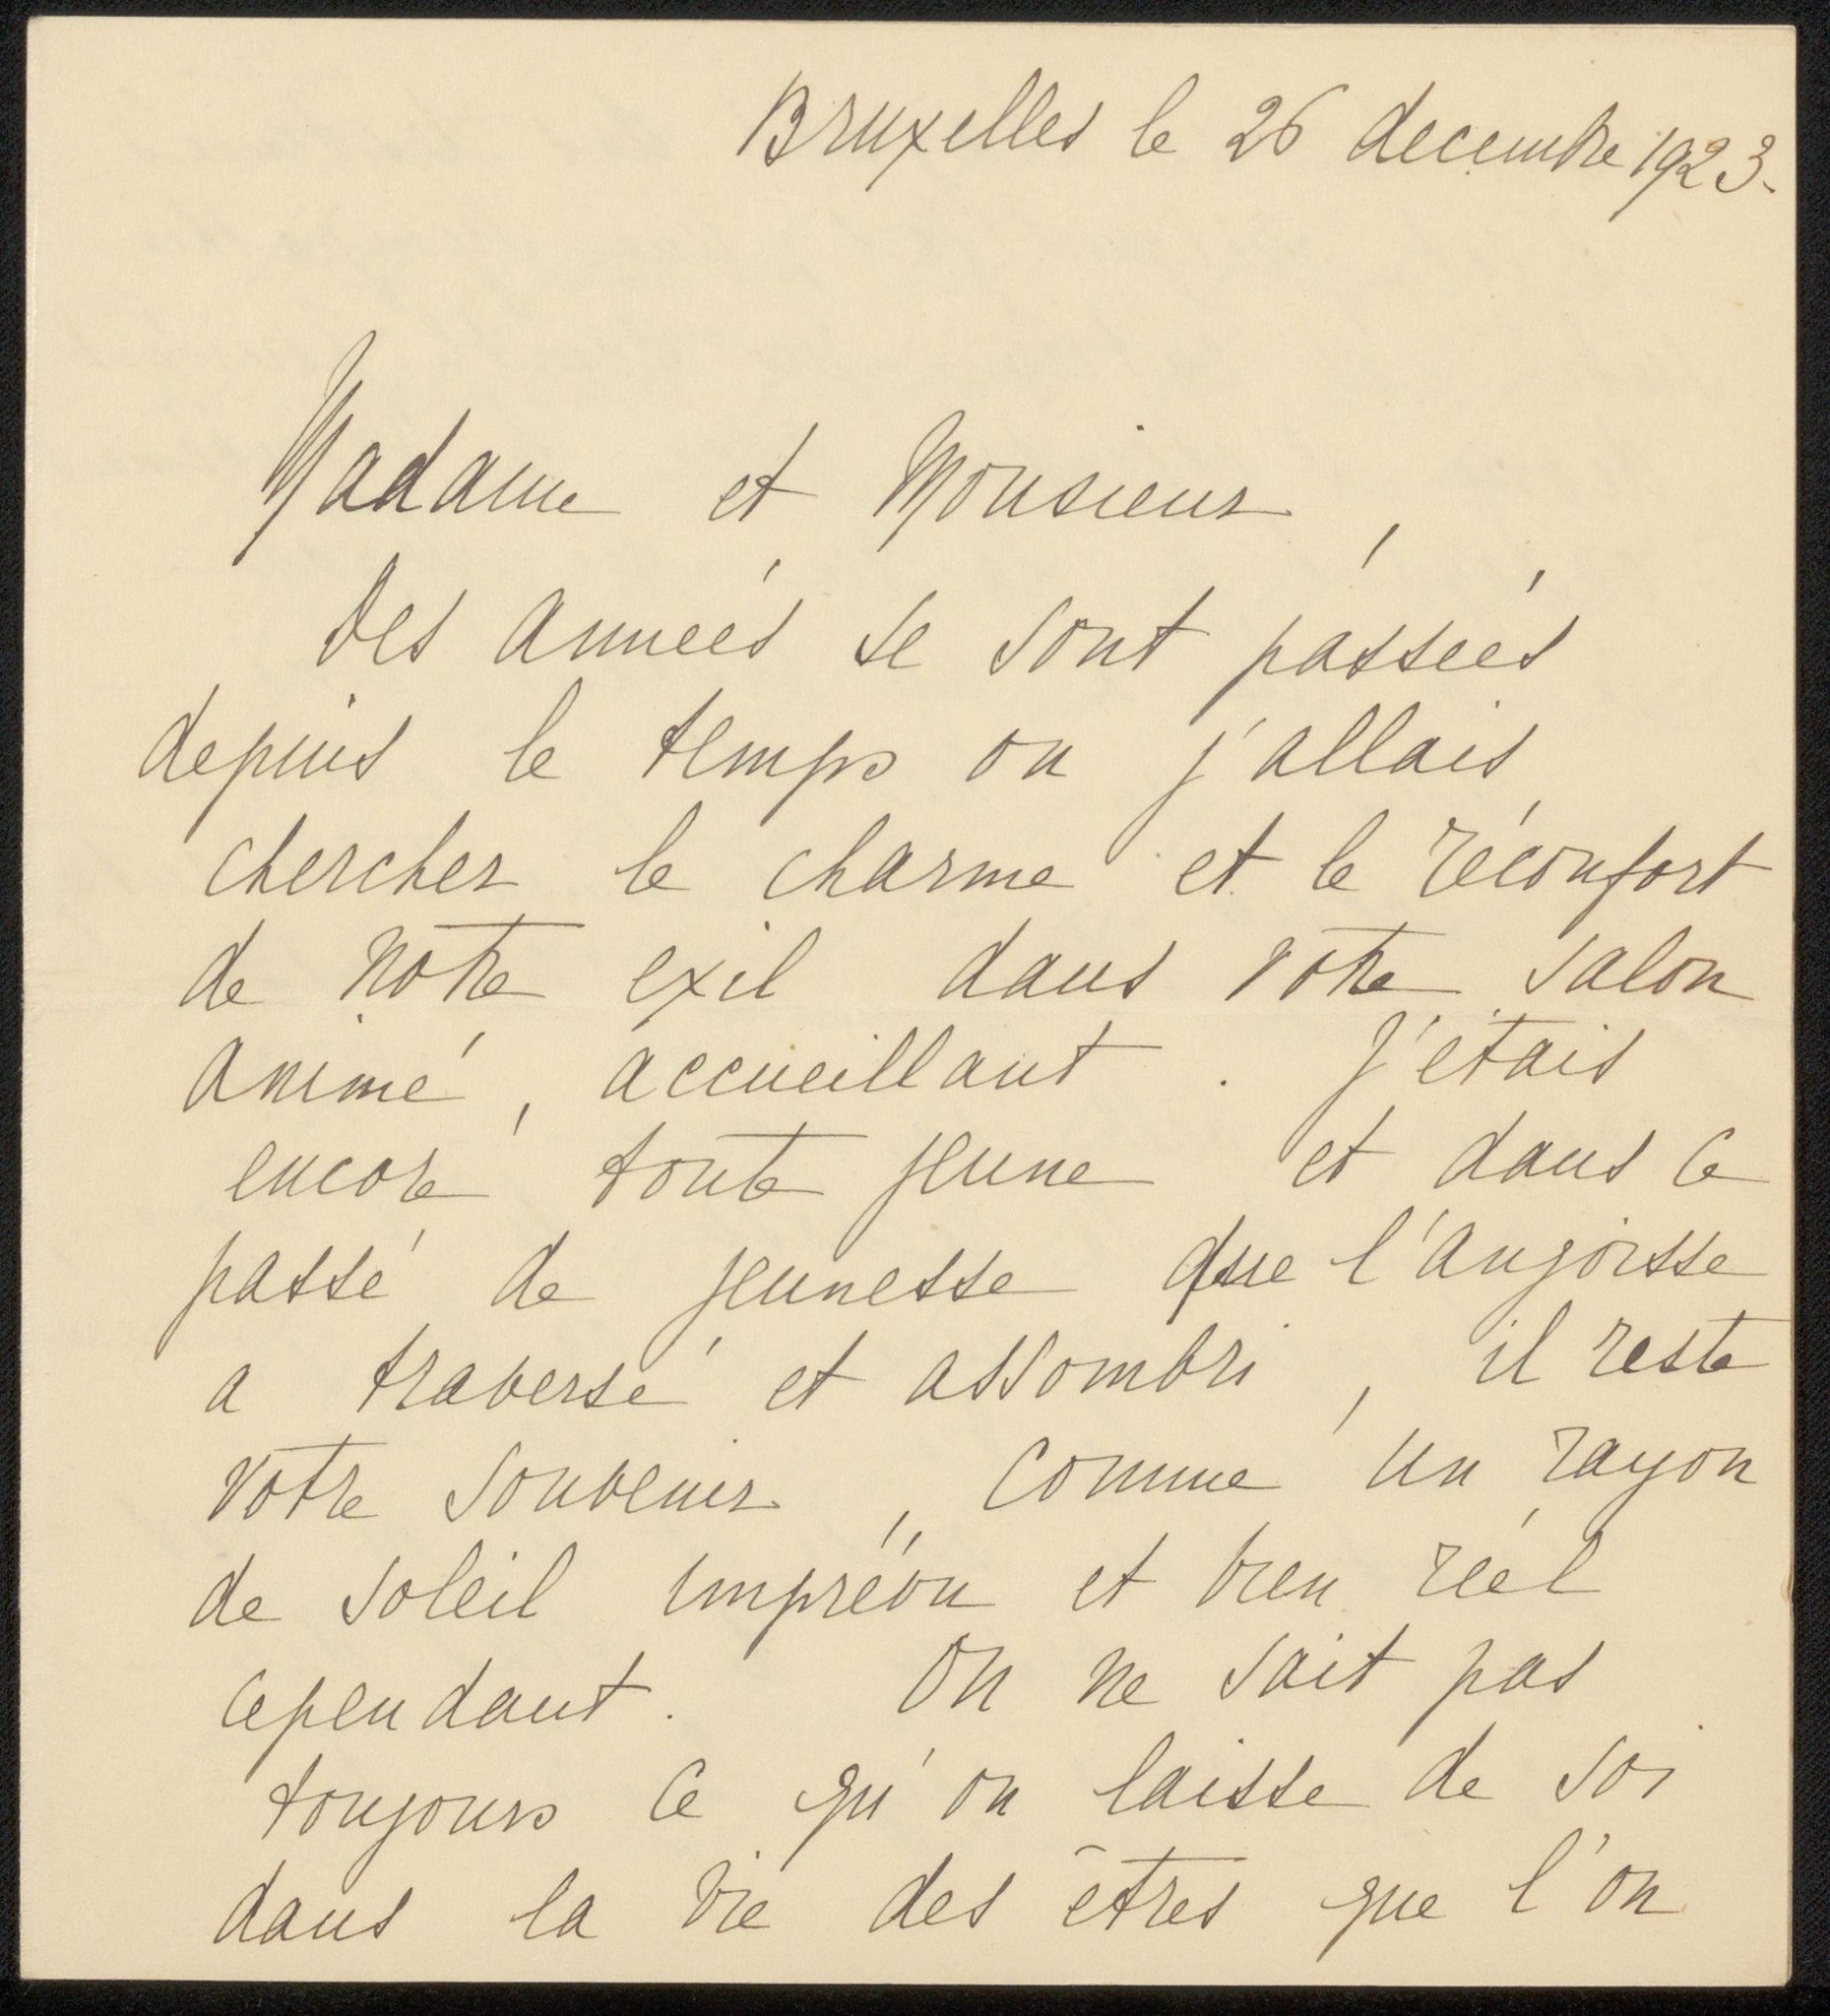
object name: letter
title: Brief aan Philip Zilcken en Henriette Wilhelmina van Baak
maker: germaine wenziner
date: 1923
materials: ink, paper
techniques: pen, writing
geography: brussels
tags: henriette wilhelmina van baak, painter, draughtsman, philip zilcken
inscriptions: collector's mark: ‘RPK’